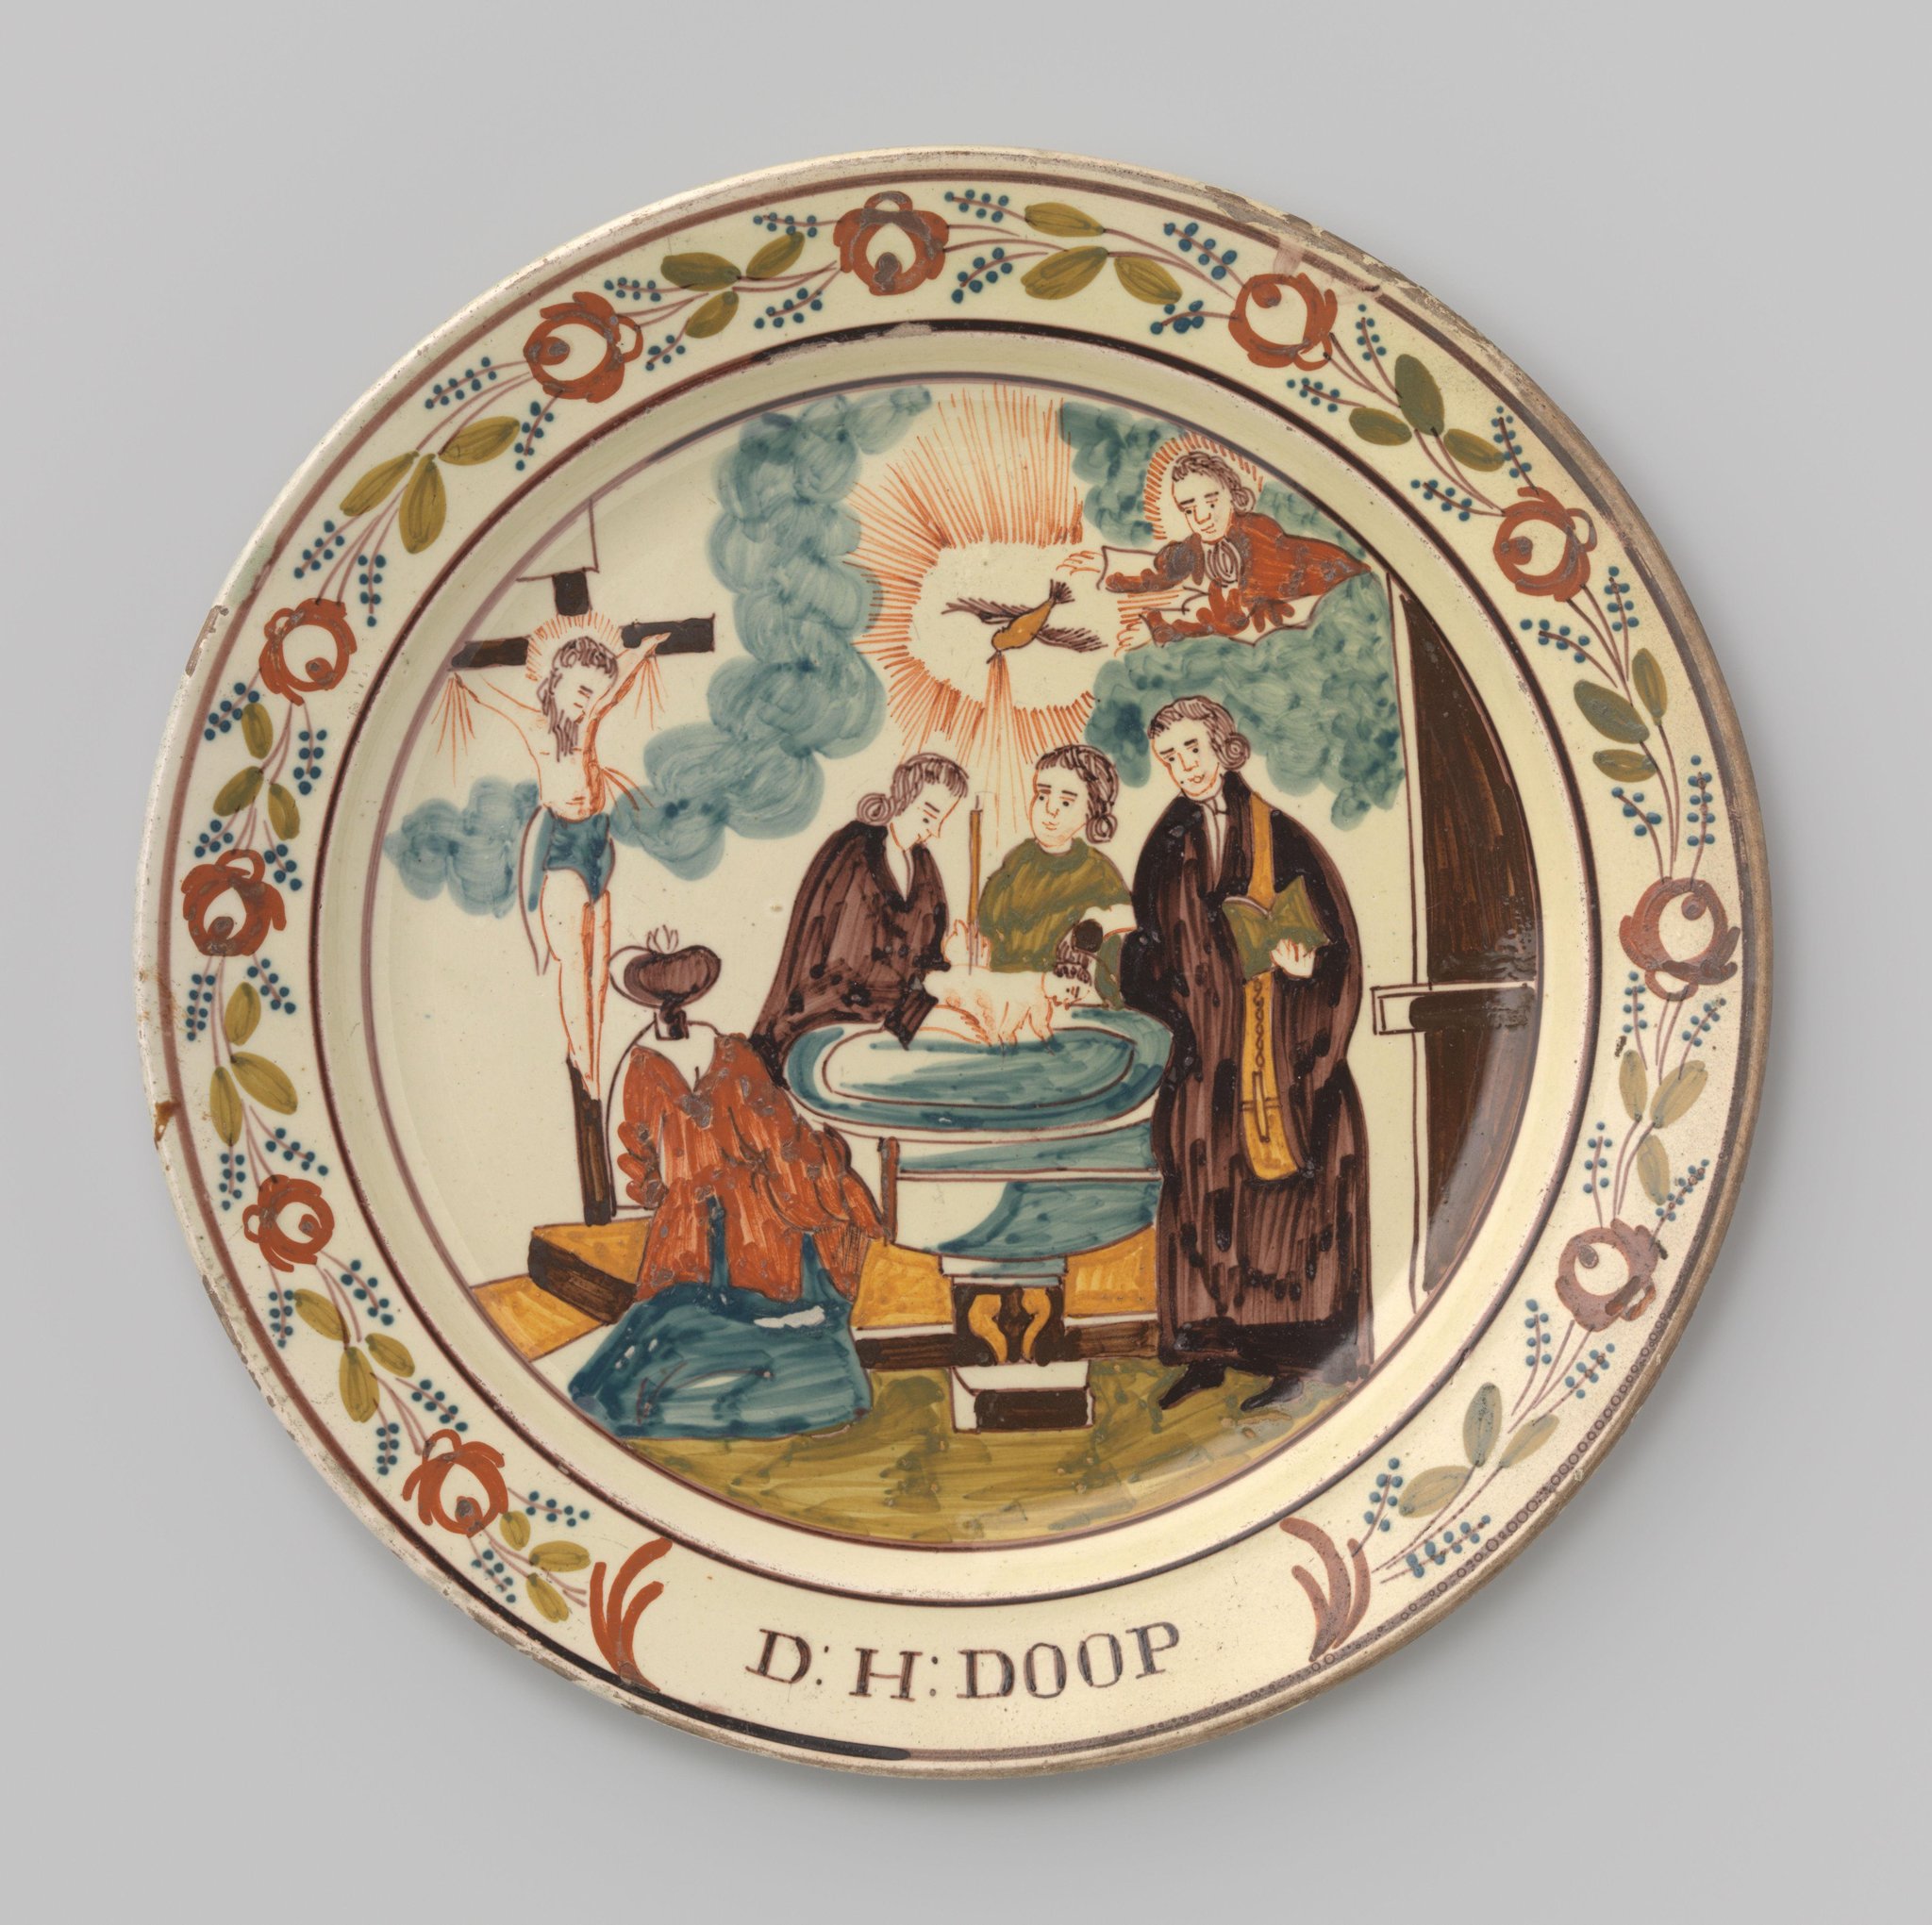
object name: plate dish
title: Bord van crême-kleurig steengoed met voorstelling van de doop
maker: piccardt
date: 1800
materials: stoneware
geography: delft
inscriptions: mark: ‘Piccardt Delft’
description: Bord van crême-kleurig steengoed (enigszins groen), versierd in rood, paars, geel, groen en blauw met voorstelling van de doop. Rand met rozen in rood, groen, paars en blauw en opschrift: D H: Doop.